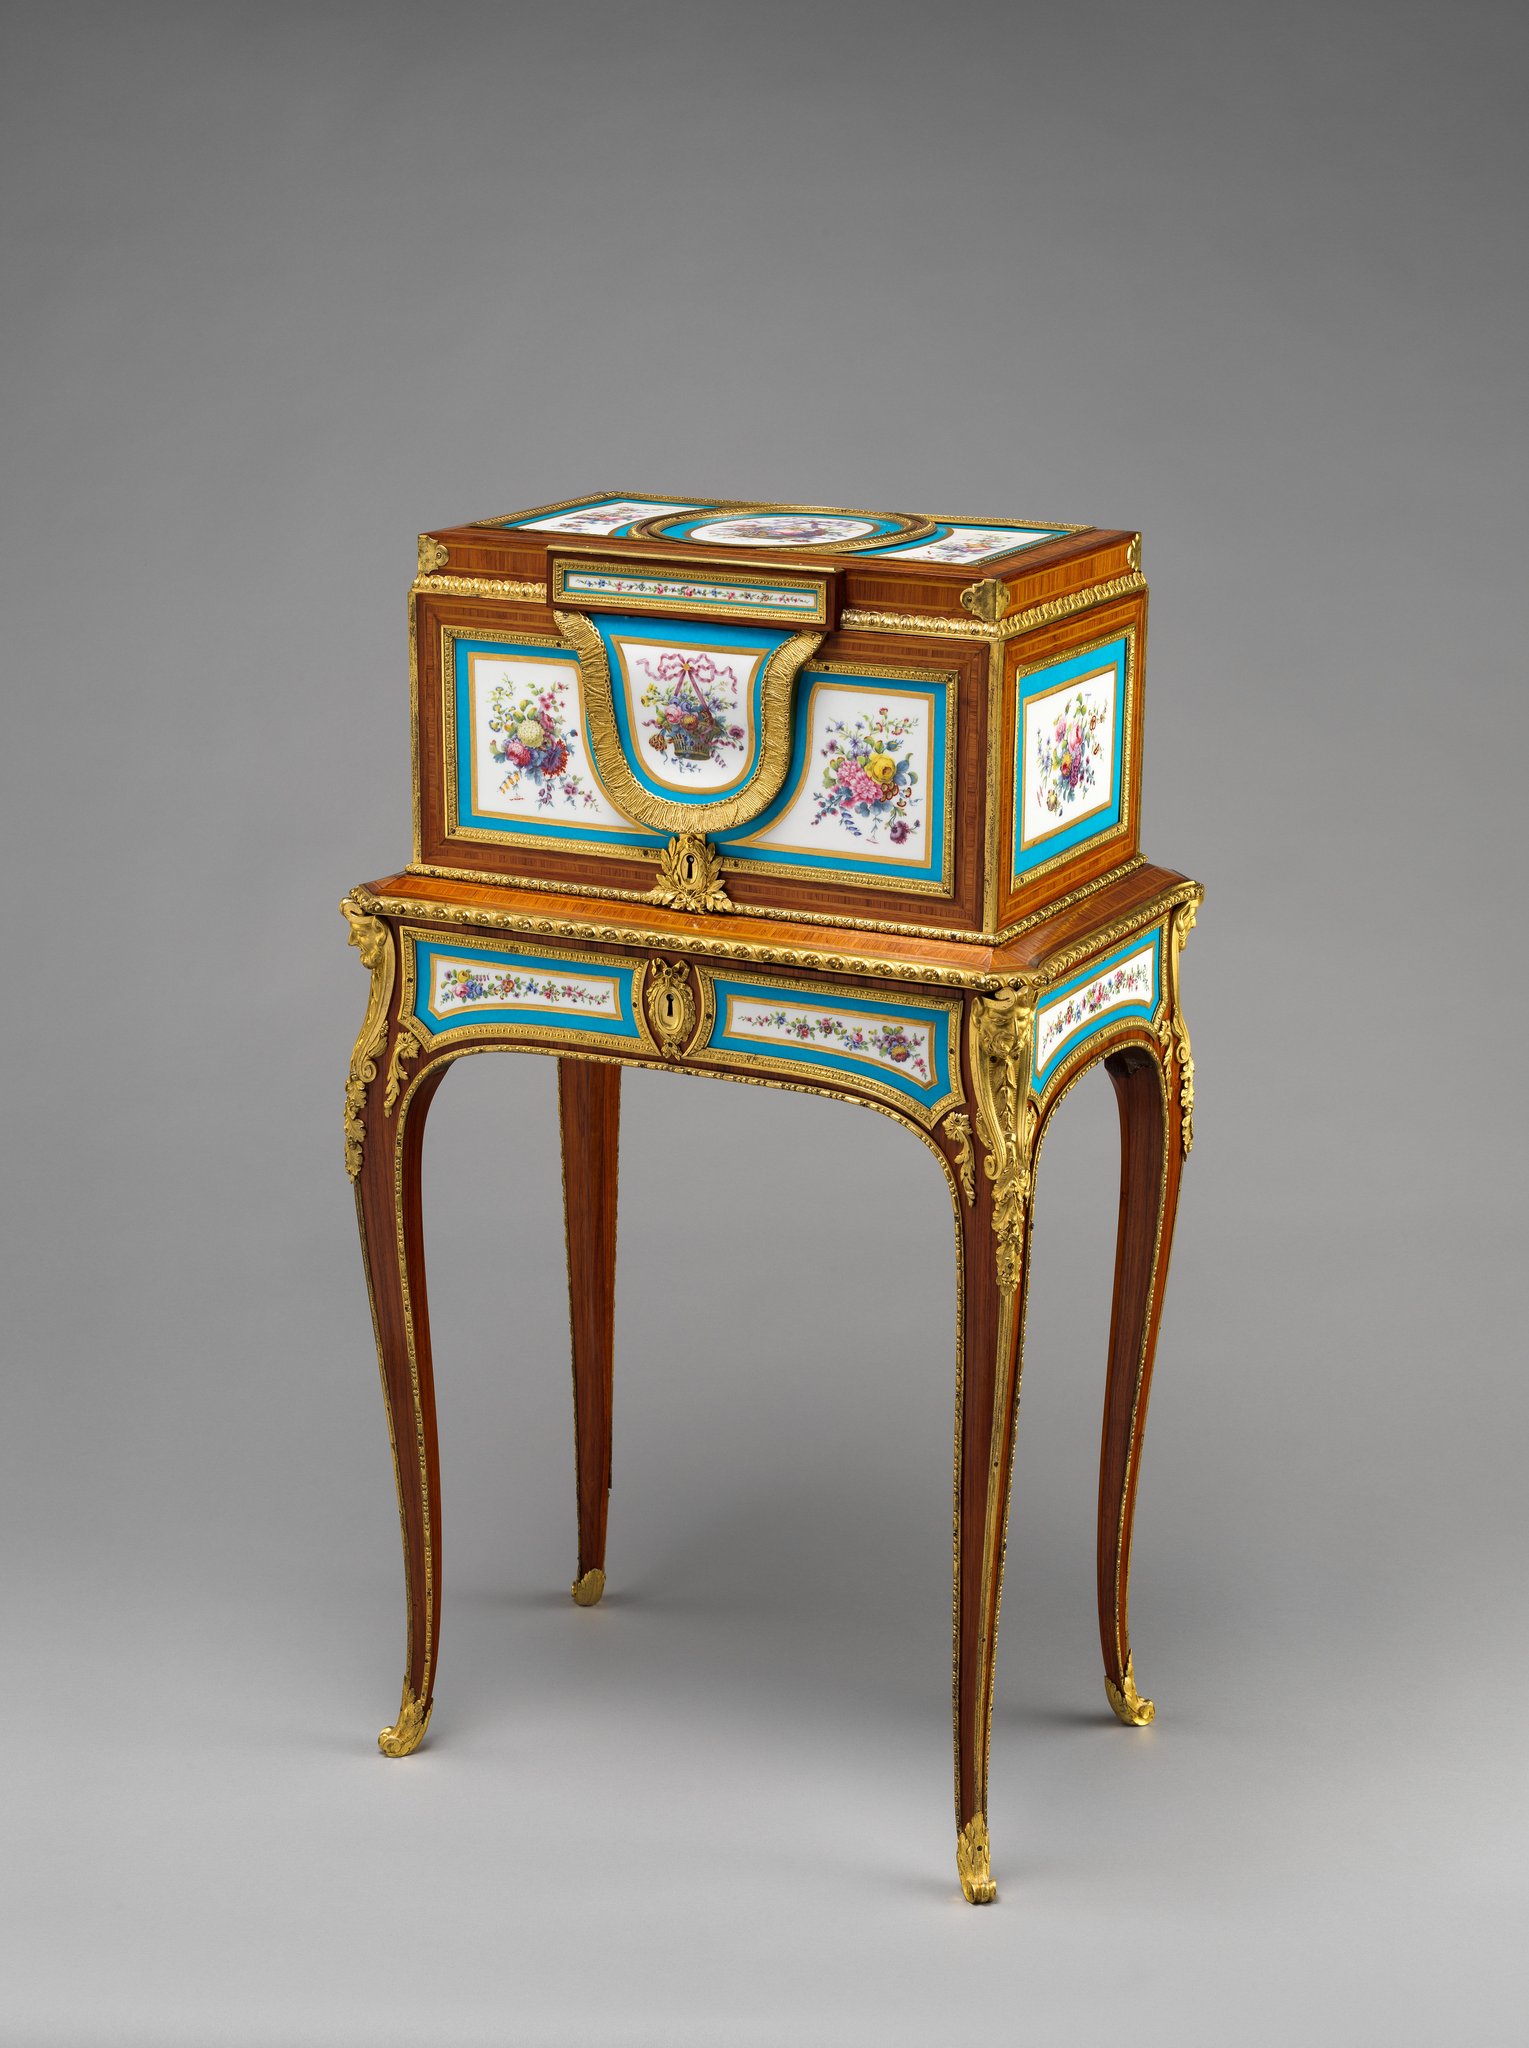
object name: jewel coffer on stand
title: Jewel coffer on stand (petit coffre à bijoux)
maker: martin carlin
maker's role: maker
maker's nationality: french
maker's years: 1725-1785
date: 1775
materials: gilt bronze, wood, soft paste porcelain, velvet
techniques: veneering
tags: flowers